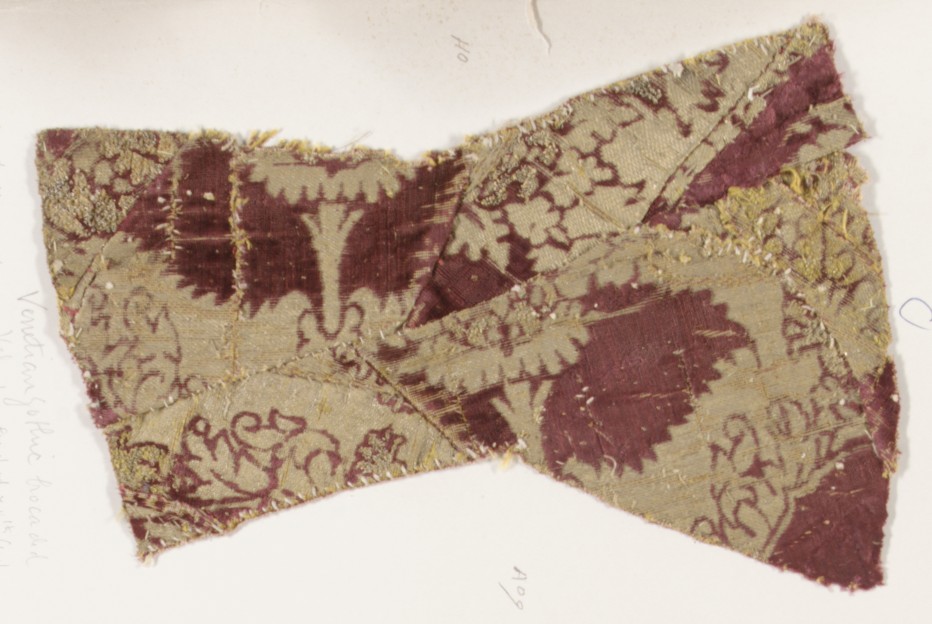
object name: fragment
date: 1467-1500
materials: metal thread, silk